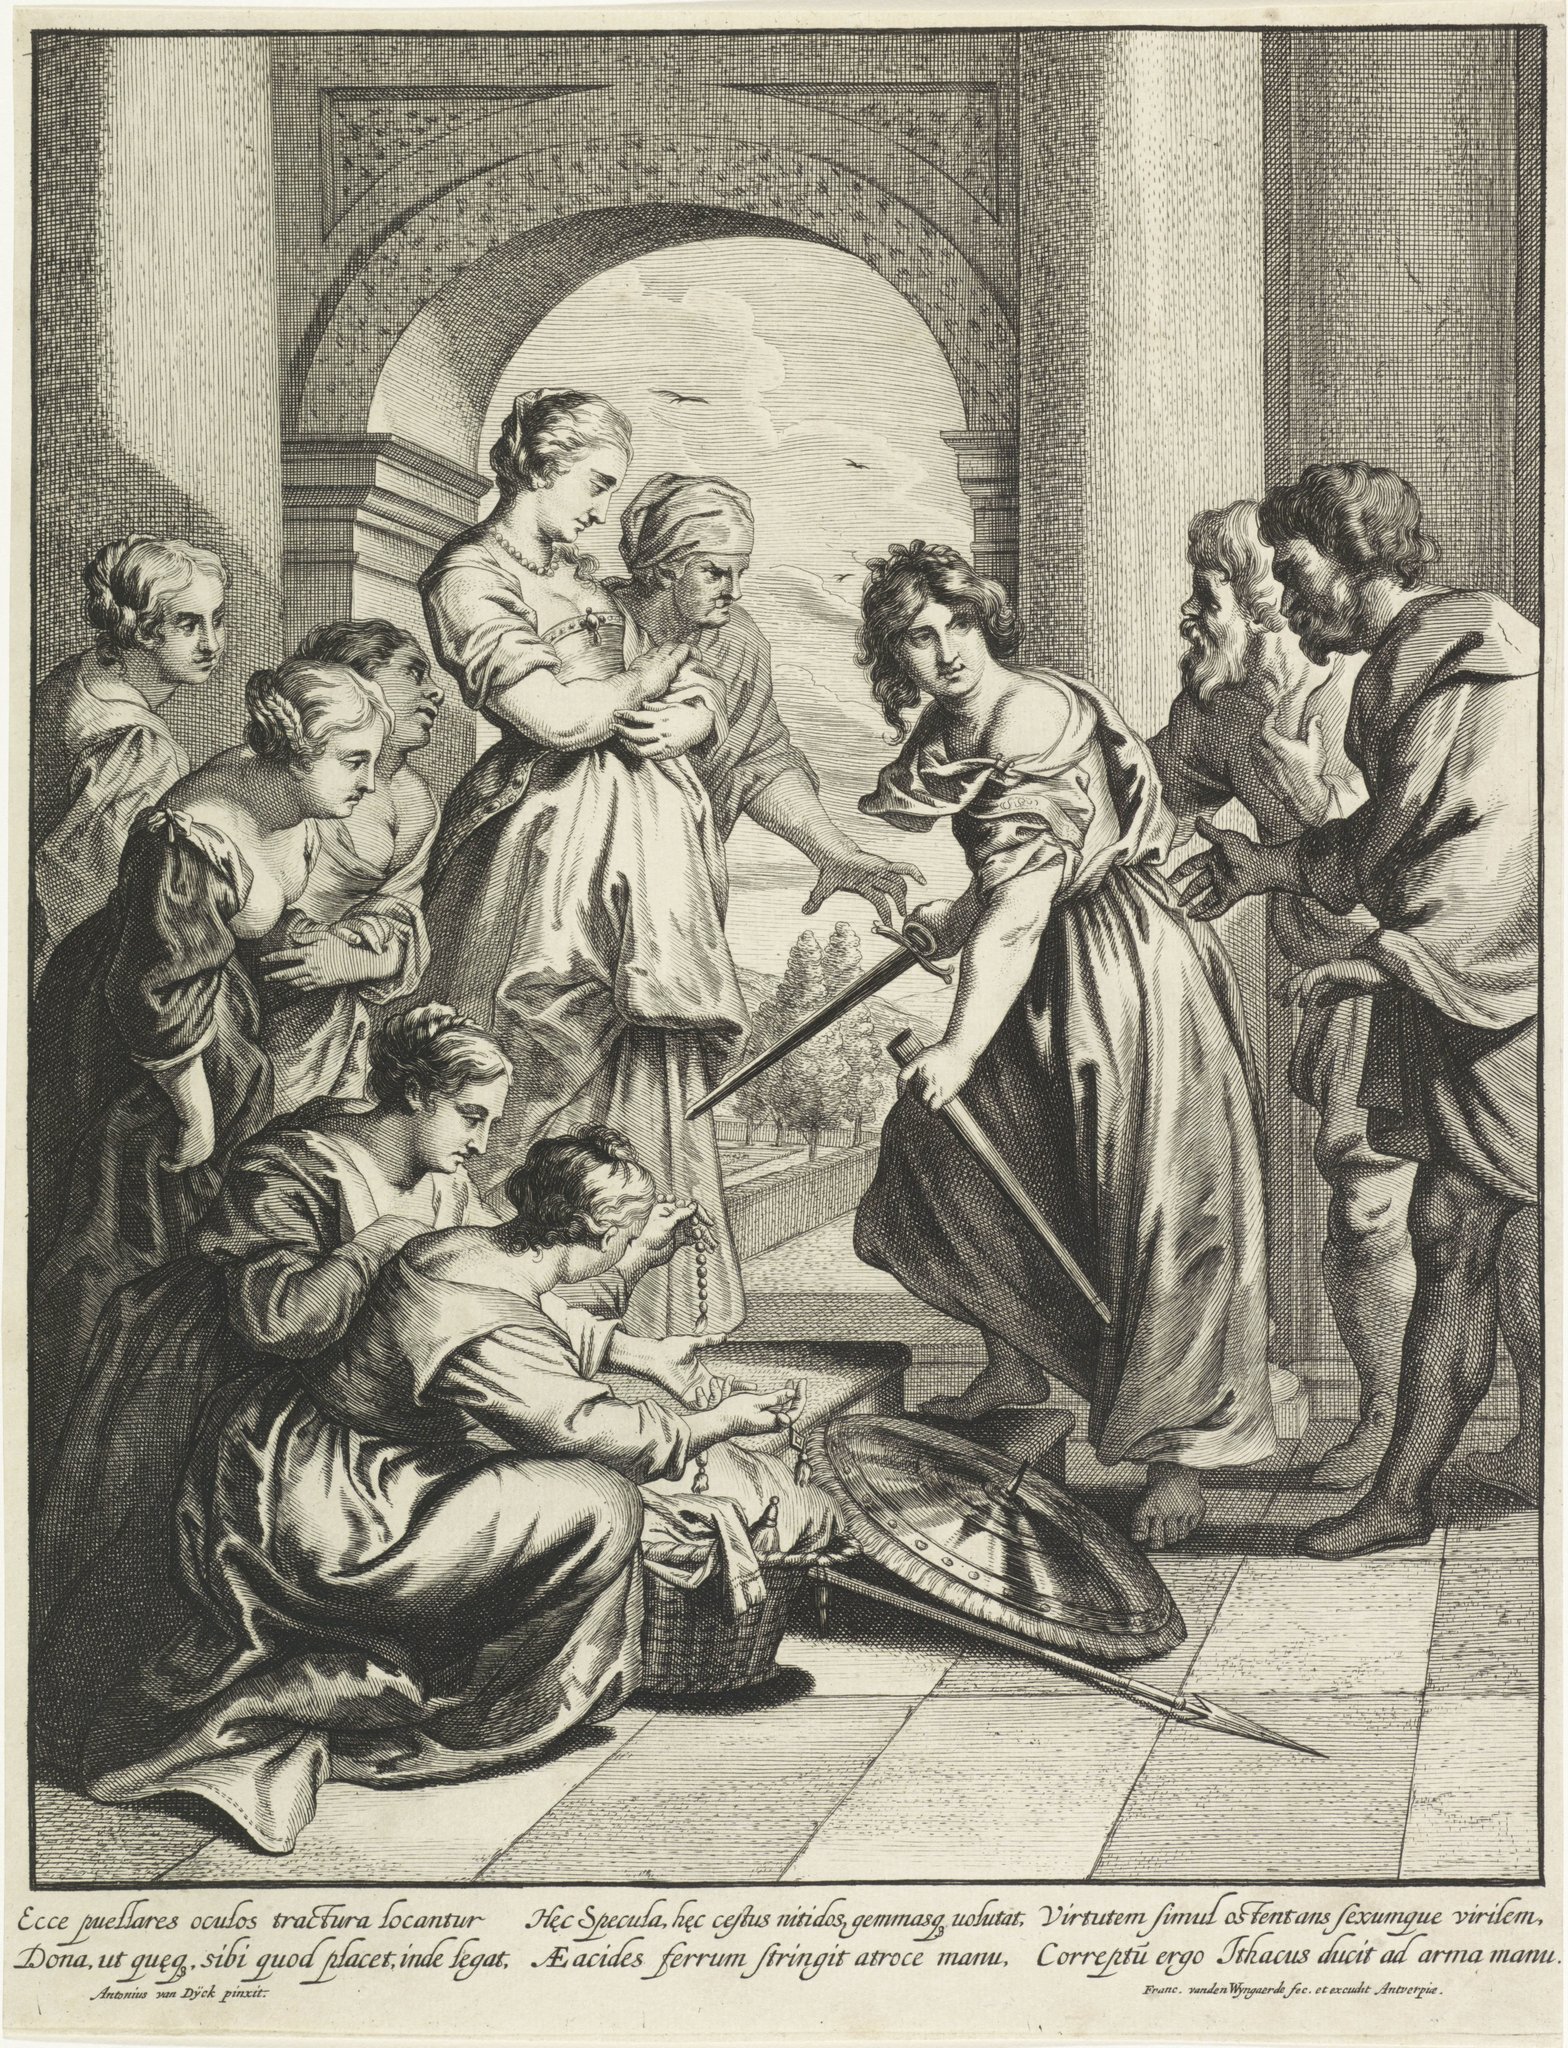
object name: print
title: Achilles en de dochters van Lycomedes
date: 1636-1679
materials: paper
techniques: engraving, etching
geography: antwerp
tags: achilles discovered among the daughters of lycomedes, i.e. achilles on scyros: when presents are brought achilles snatches up the weapons and thus betrays his identity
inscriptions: collector's mark: Lugt 240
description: De dochters van Lycomedes zitten gebogen over een mand met juwelen terwijl Achilles, vermomd als vrouw, zijn zwaard trekt. Achilles wordt door twee mannen gegrepen, aan zijn voeten zijn schild en een speer. In de marge een zesregelig onderschrift, in twee kolommen, in het Latijn.